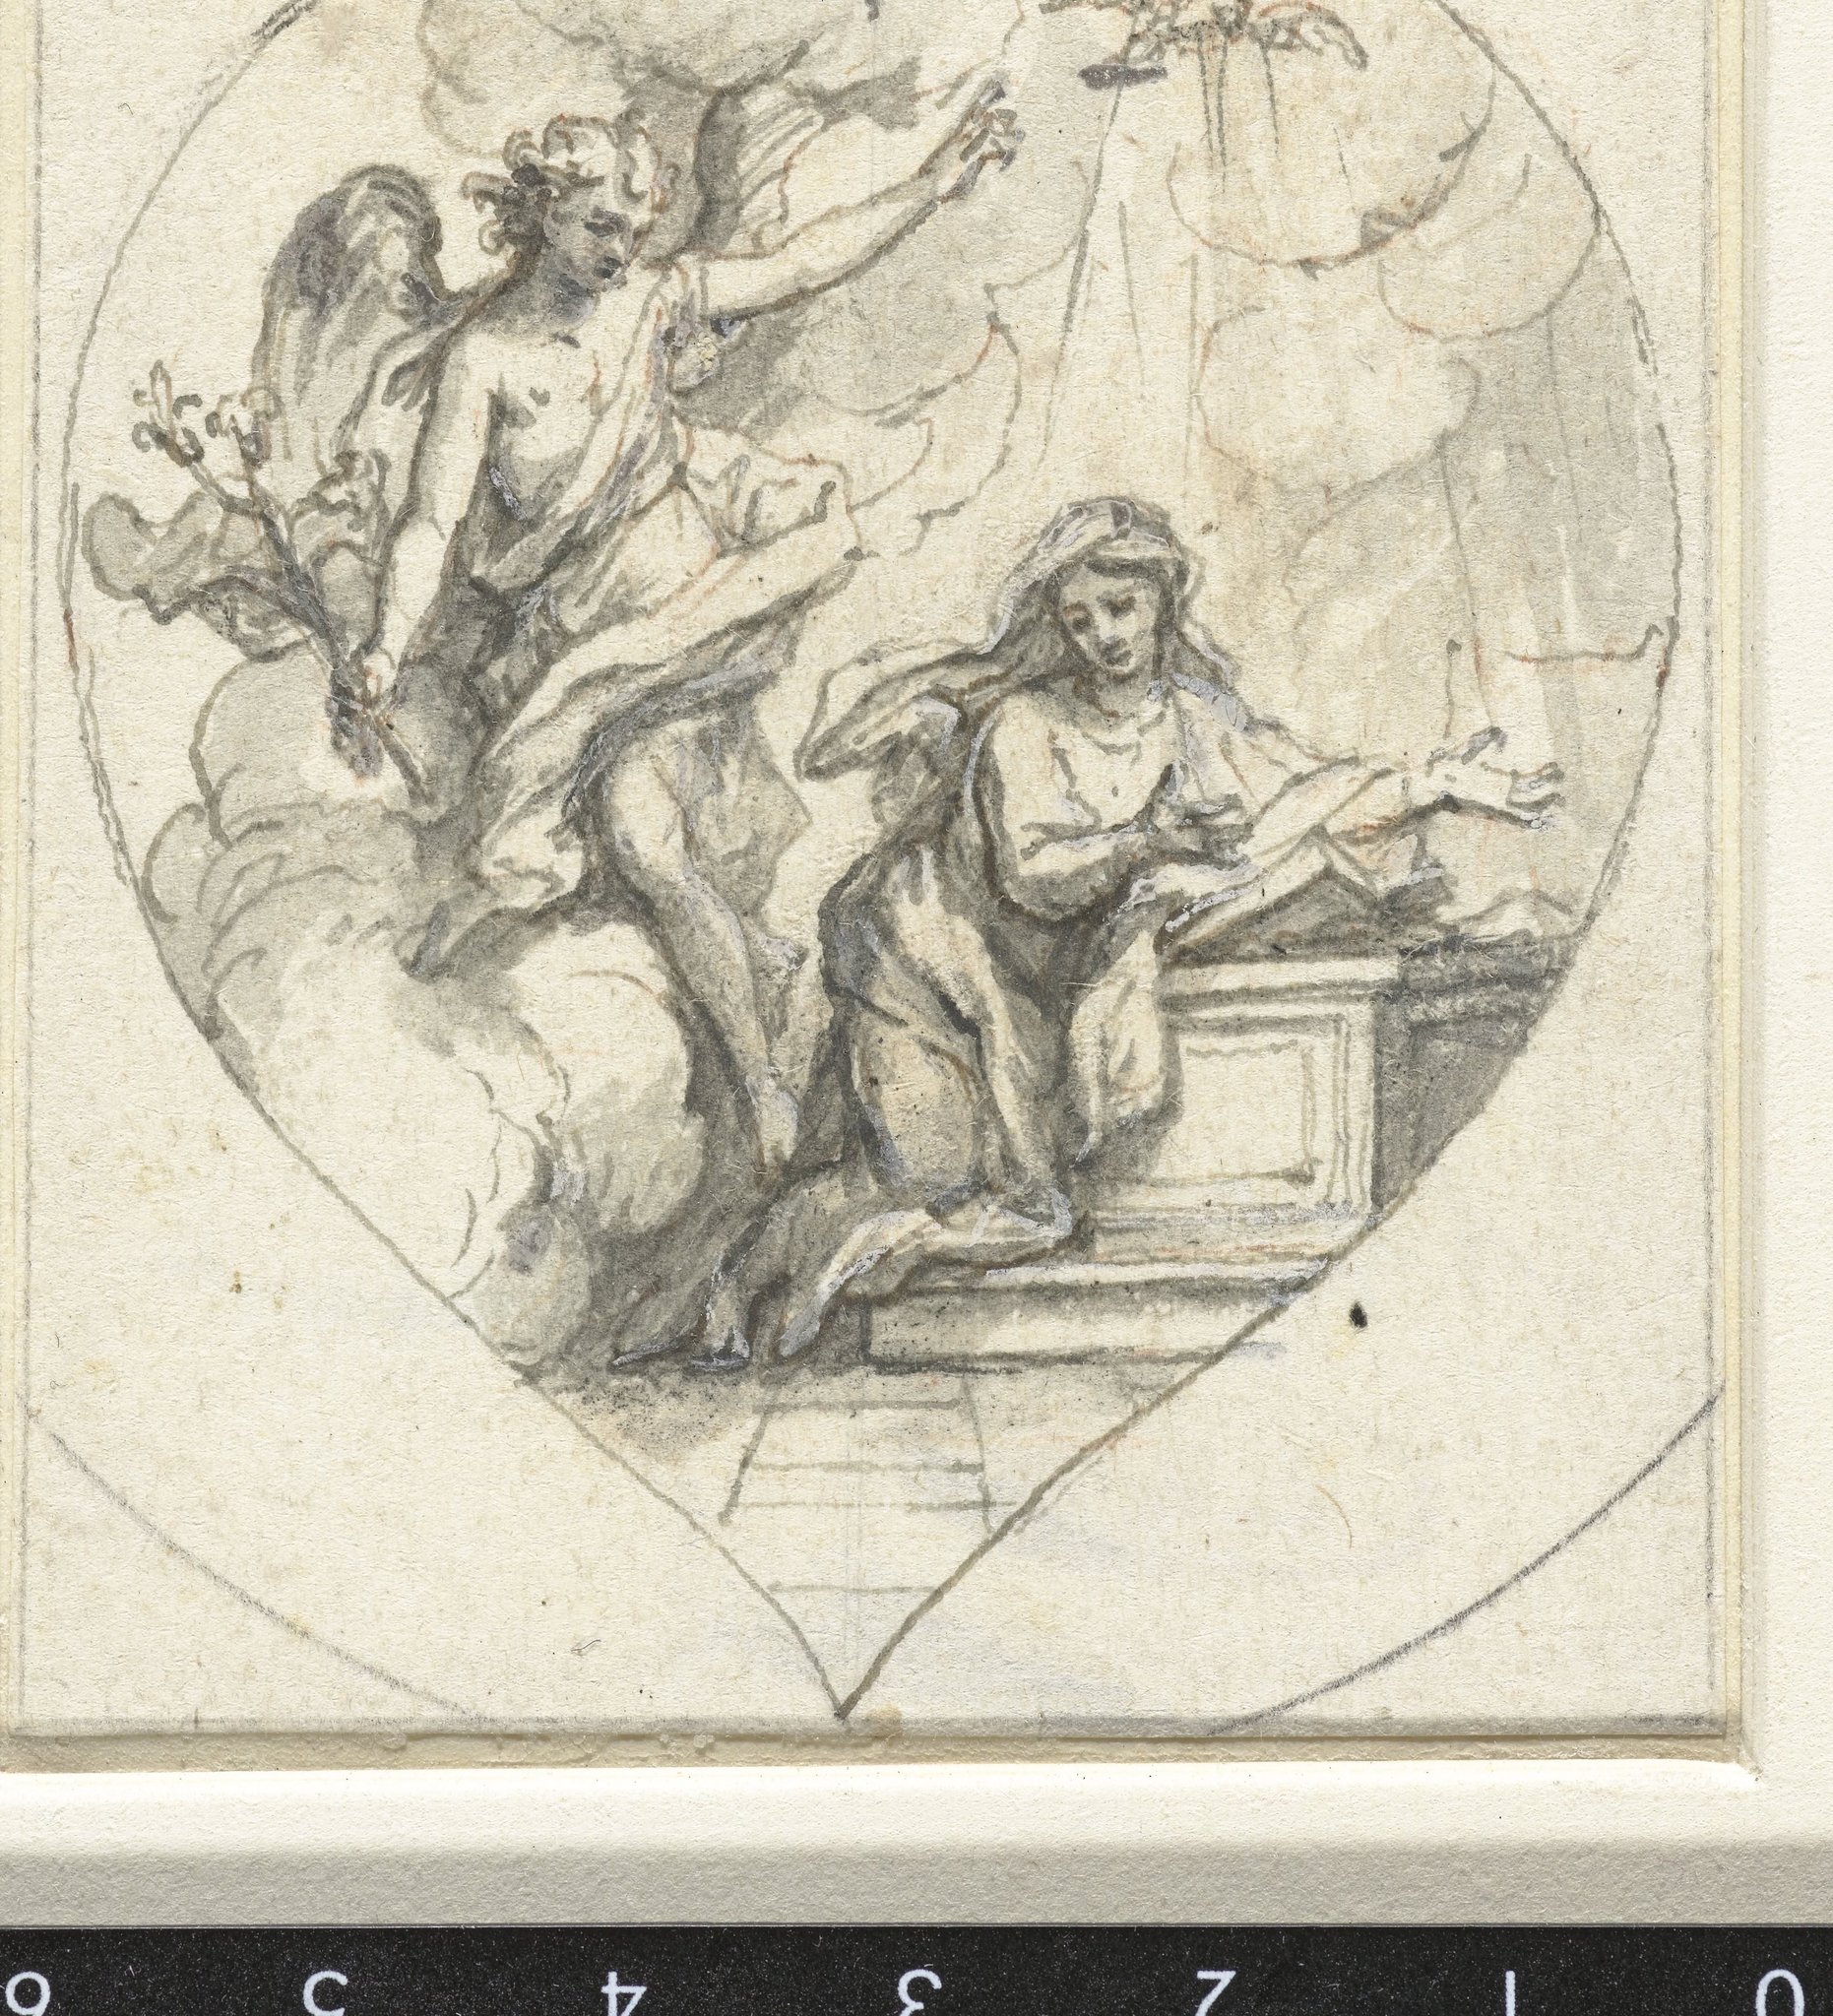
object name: drawing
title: Verkondiging aan Maria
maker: Anonymous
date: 1600-1699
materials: ink, paper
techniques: brush, pen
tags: the annunciation: mary, usually reading, is visited by the angel (sometimes a woman overhears the conversation)